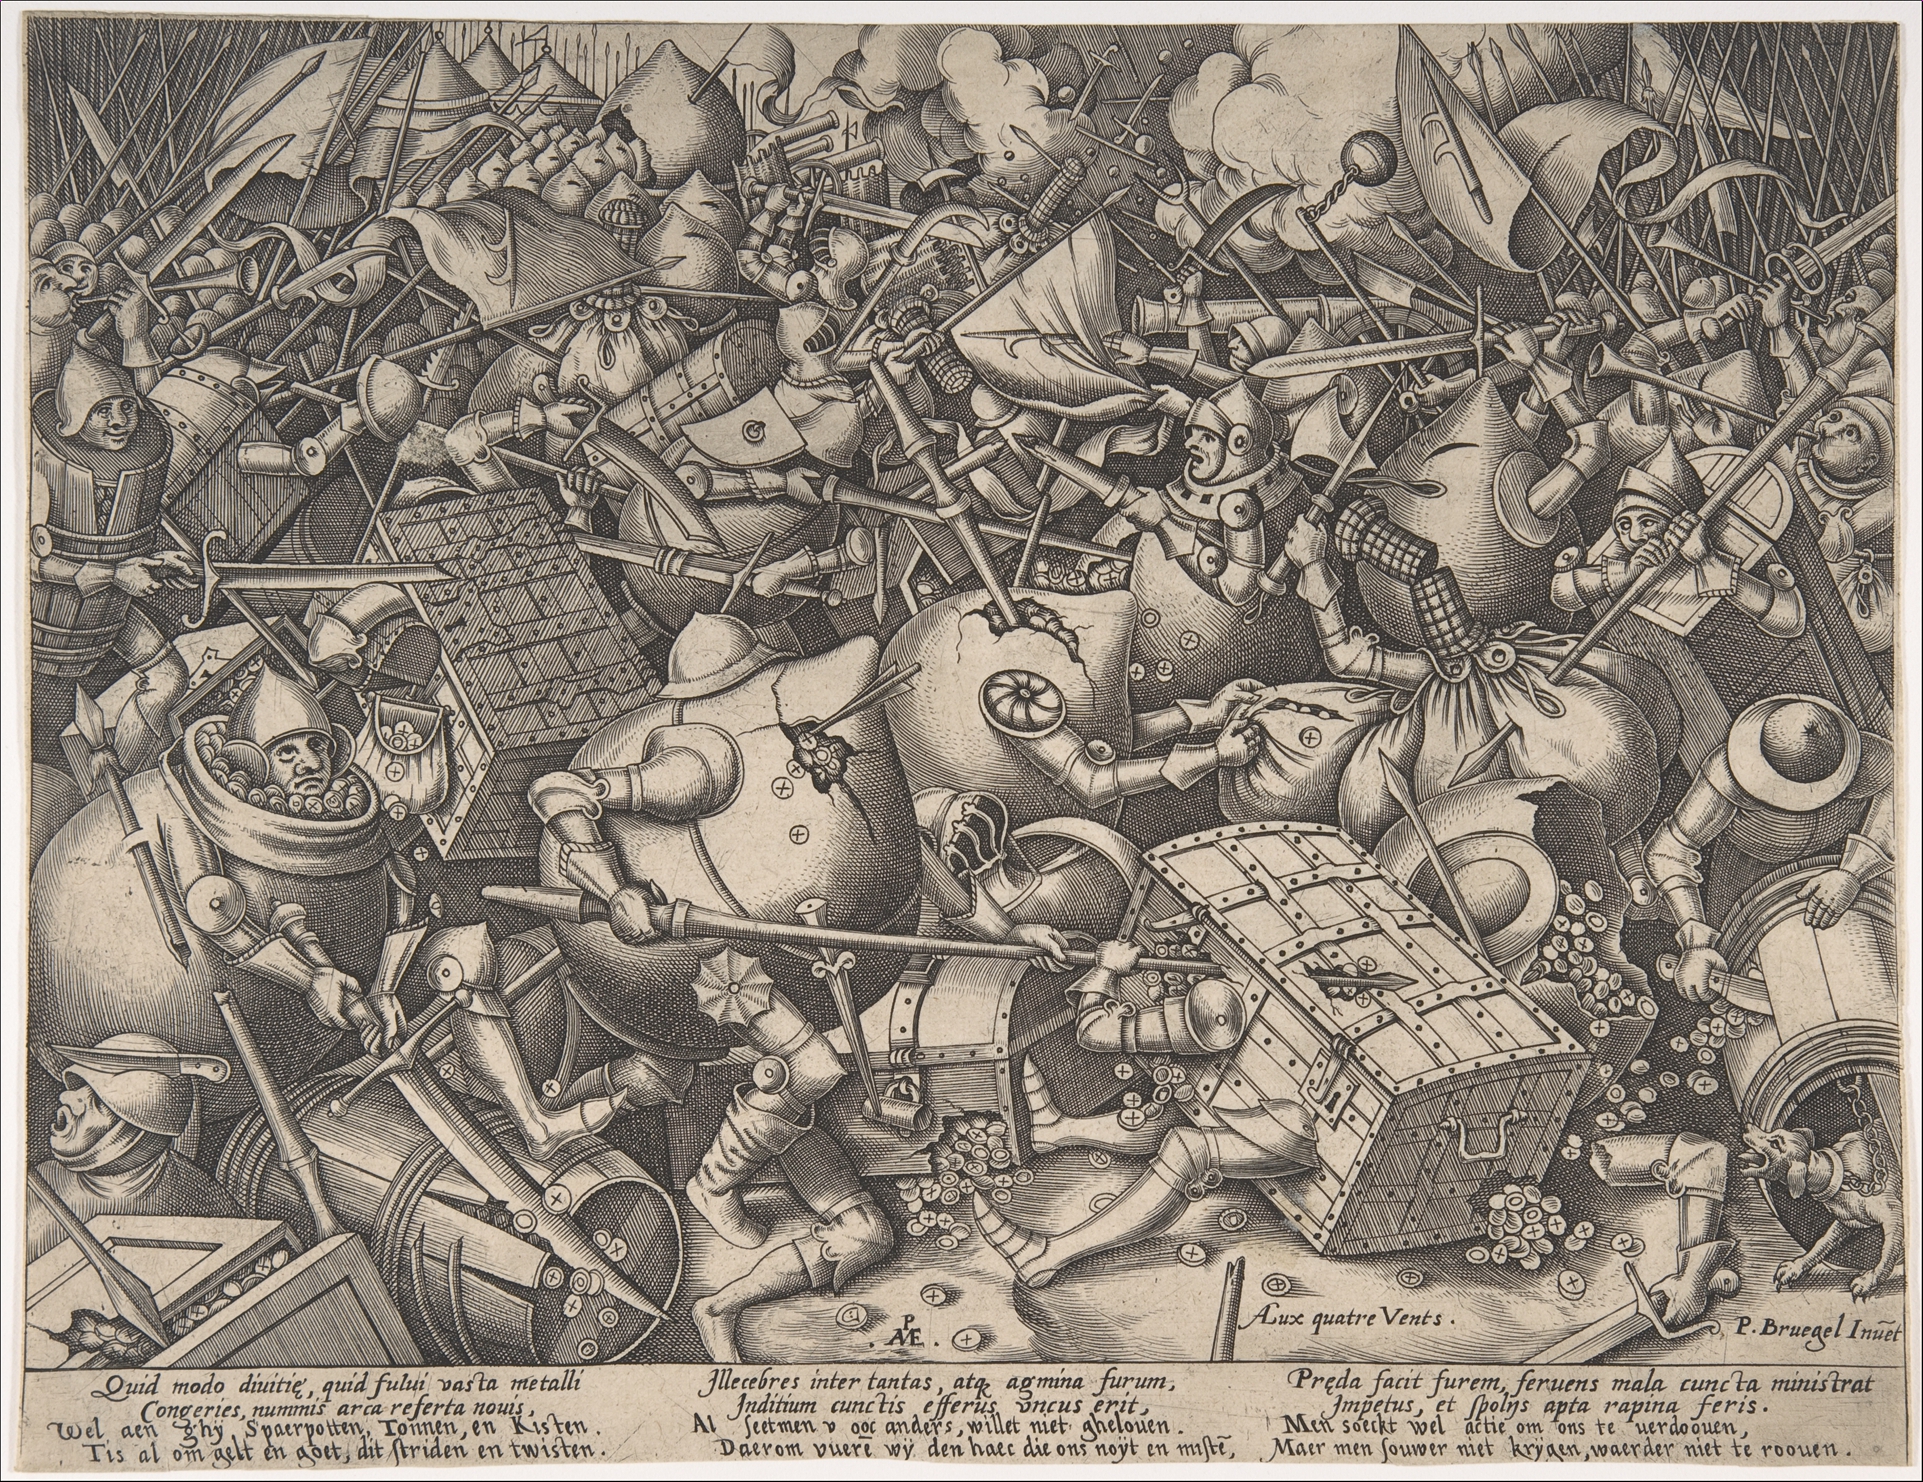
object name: print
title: The Battle about Money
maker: pieter van der heyden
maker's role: artist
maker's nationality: netherlandish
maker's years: 1525-1569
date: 1570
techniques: engraving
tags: battles,soldiers,weapons,coins,chests